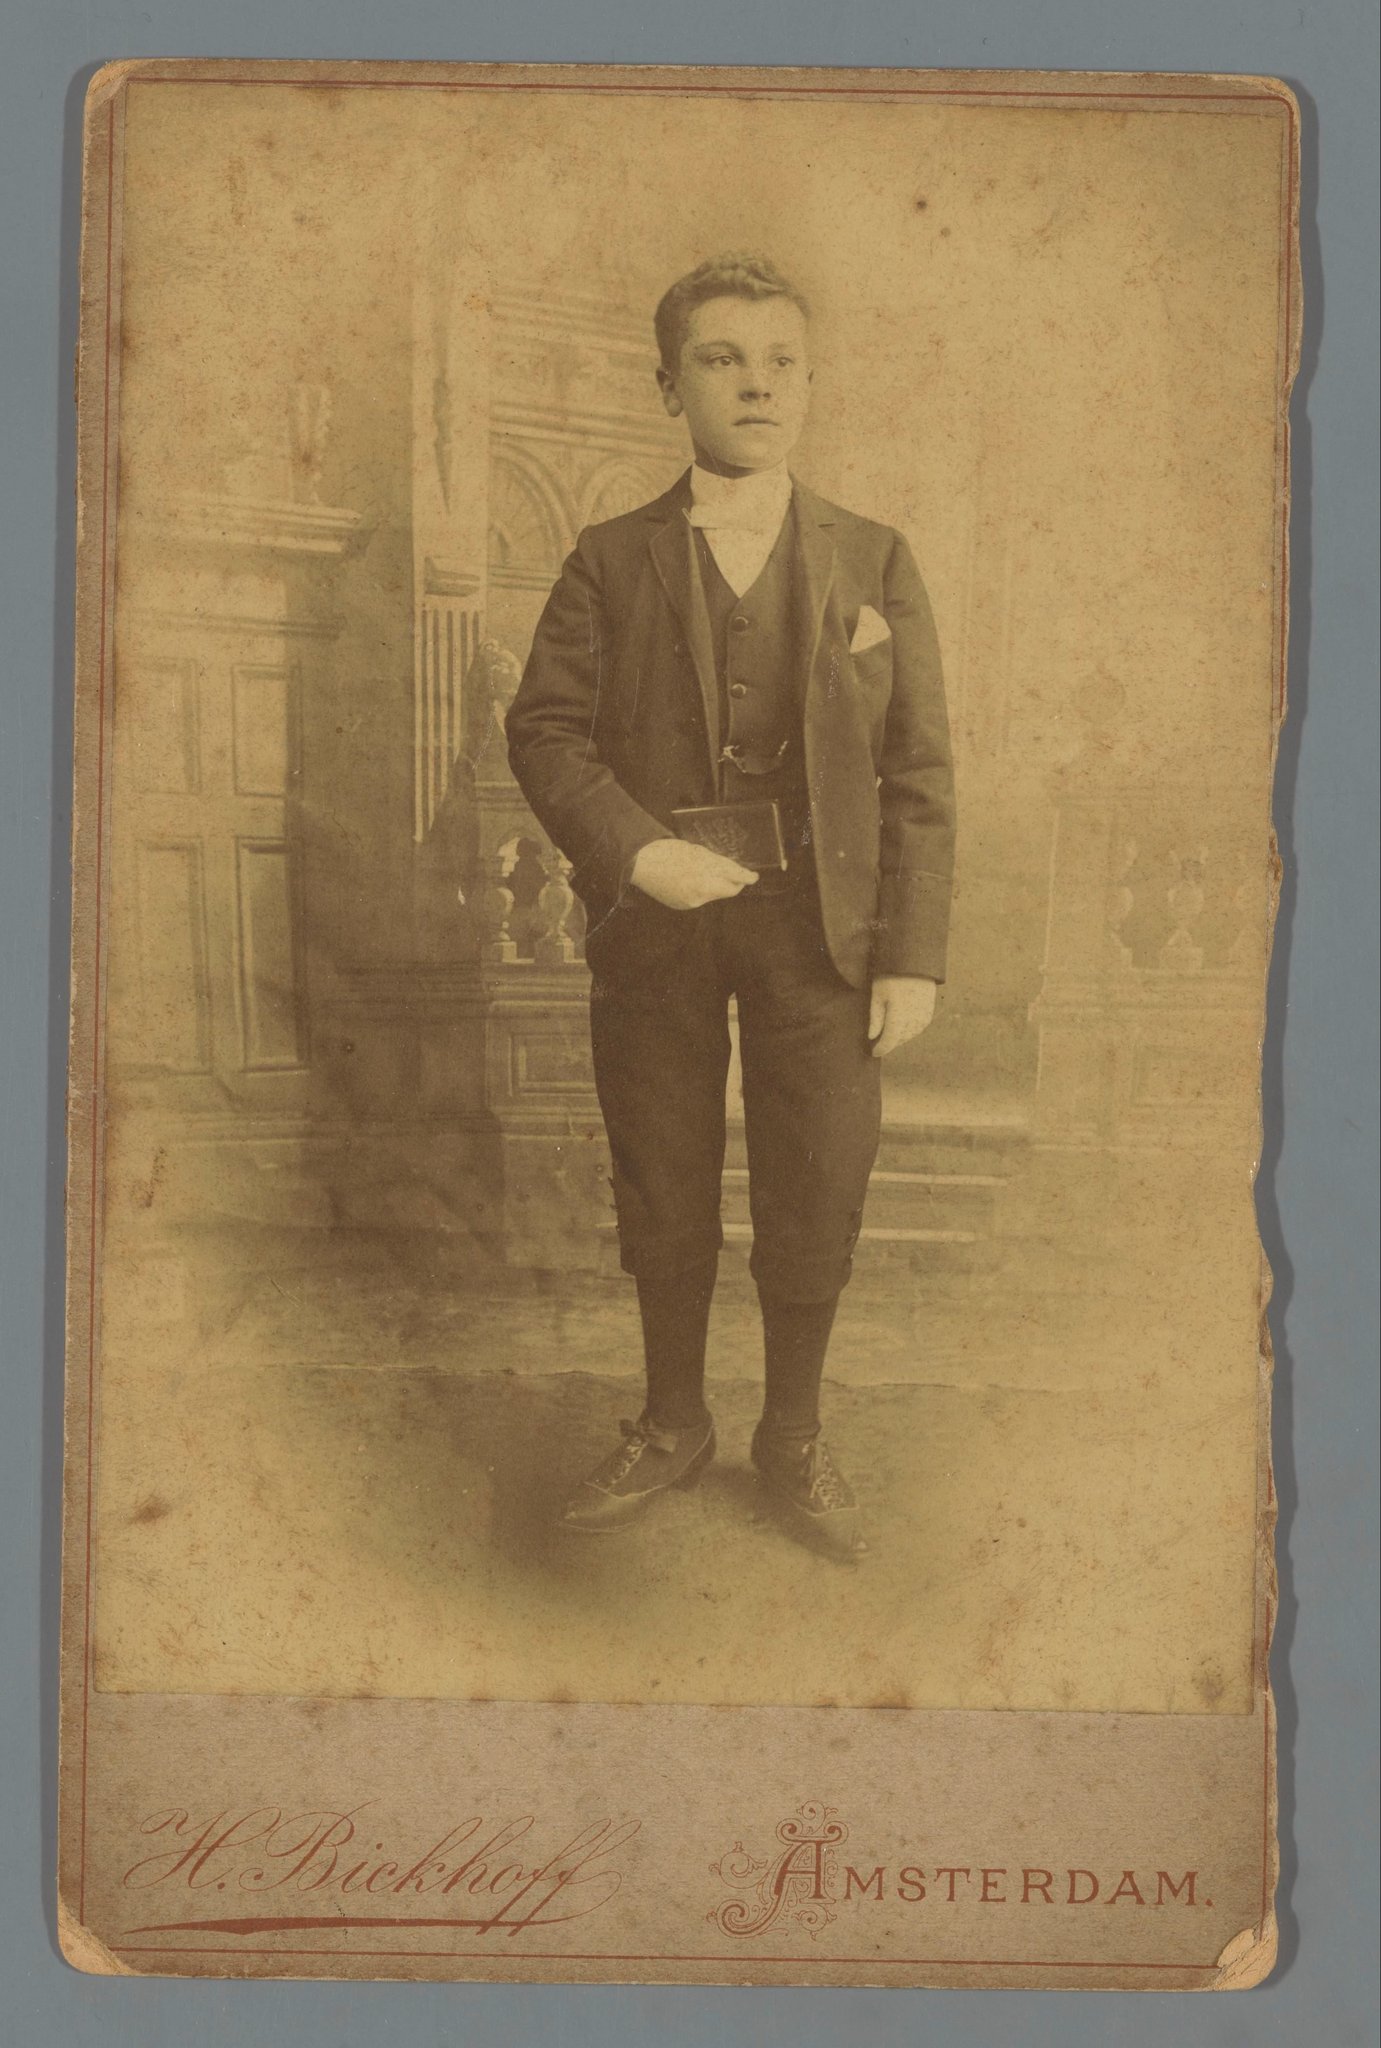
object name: cabinet photograph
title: Portret van een onbekende jongen die vermoedelijk communie gaat doen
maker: henri bickhoff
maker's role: fotograaf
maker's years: 1866-1933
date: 1890-1930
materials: cardboard, photographic support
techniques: albumen print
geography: amsterdam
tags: first communicant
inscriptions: name: ‘Bickhof[...] St. Luciensteeg Amsterd[...]’